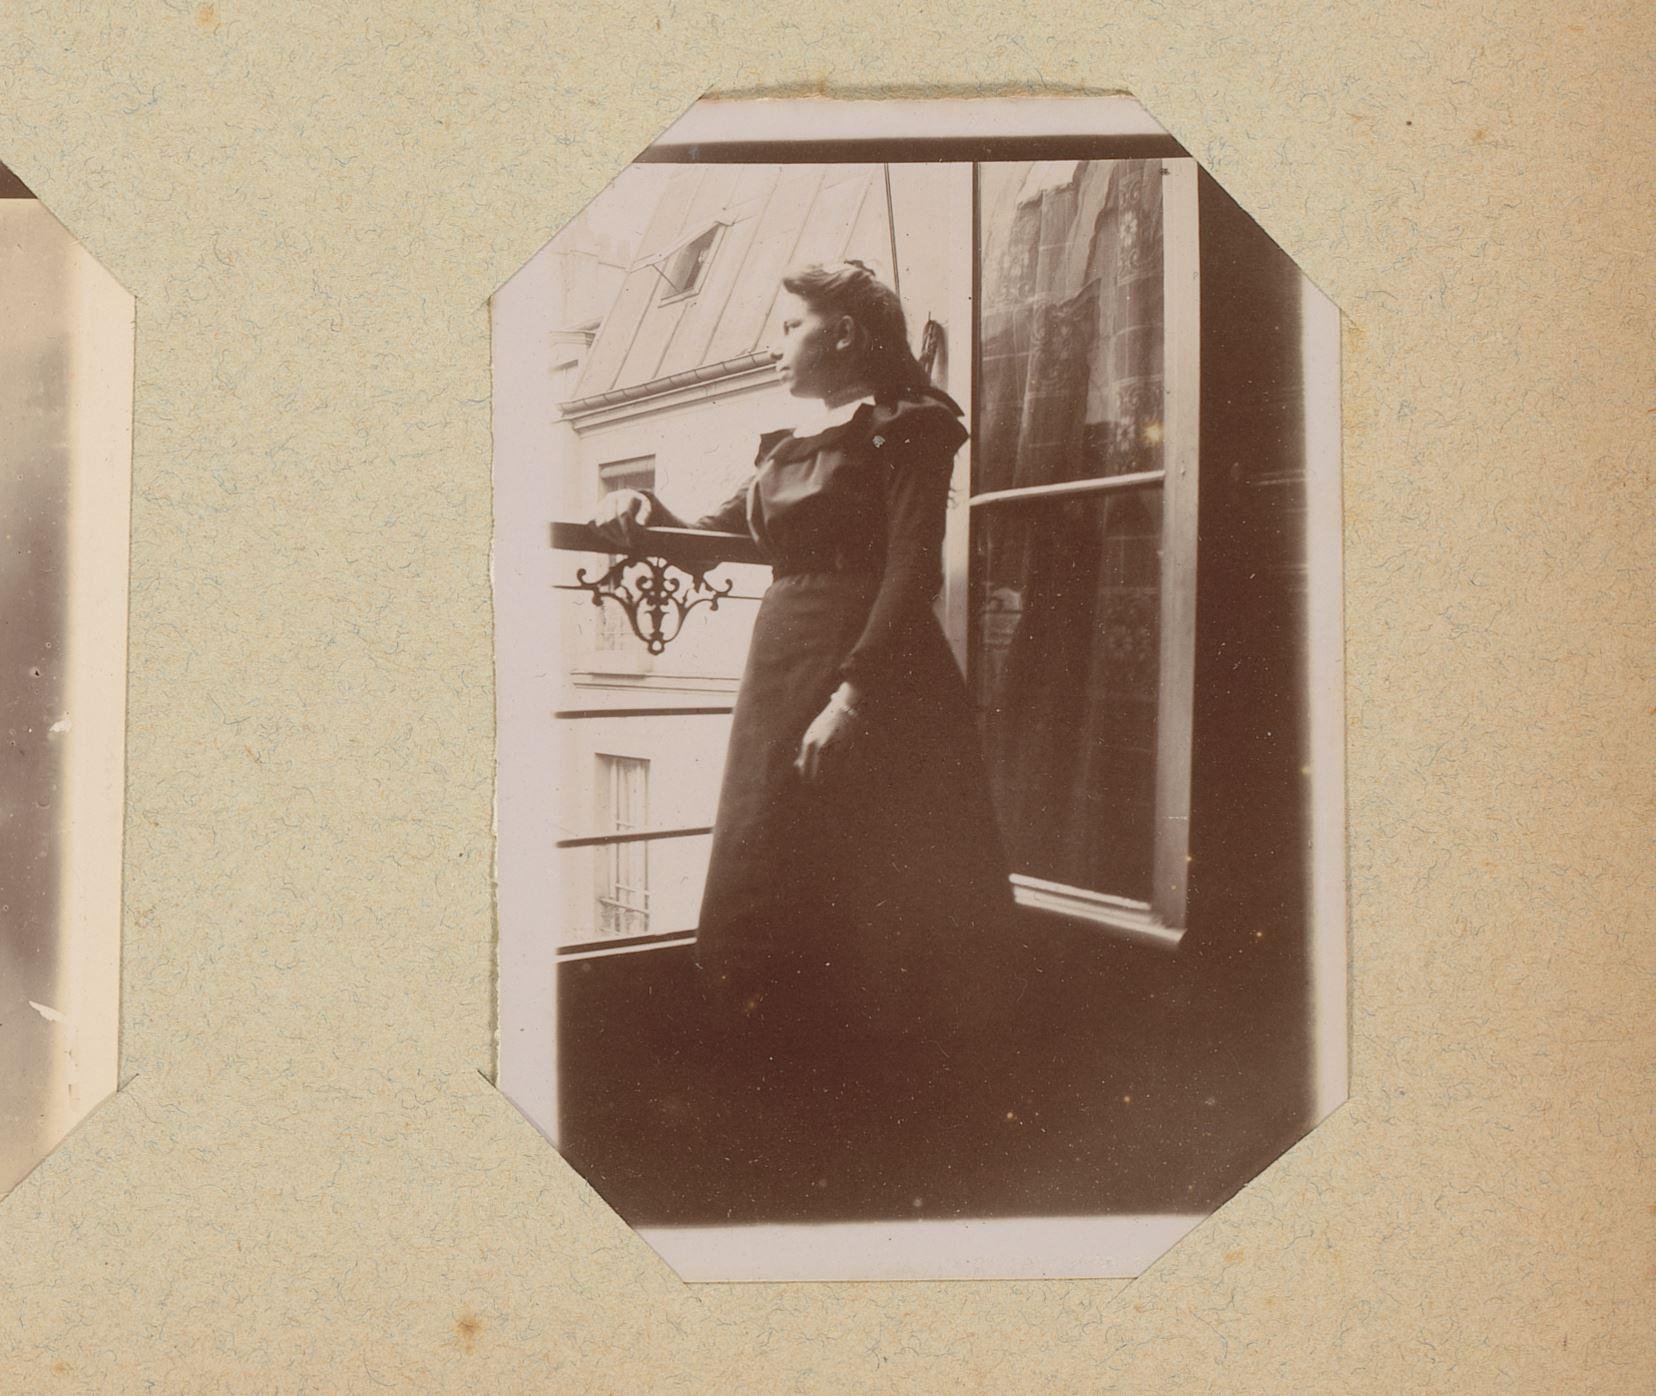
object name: photograph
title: Meisje bij een raam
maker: Anonymous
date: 1897-1900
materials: paper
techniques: gelatin silver print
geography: france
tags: girl (child between toddler and youth), france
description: Over de foto is een ander negatief afgedrukt van een voorstelling van bomen.